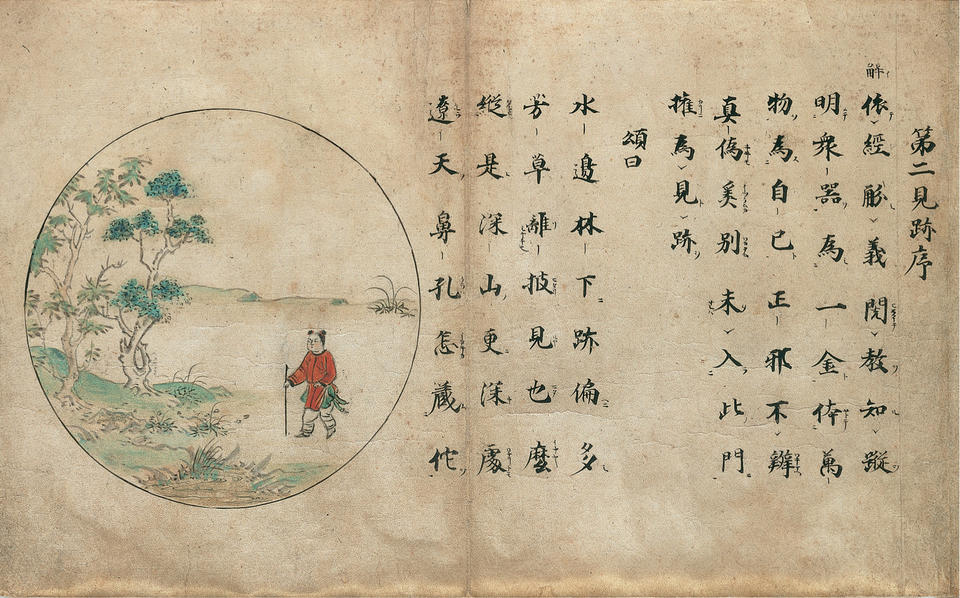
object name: handscroll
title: Ten Verses on Oxherding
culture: japanese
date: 1278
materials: ink, paper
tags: men,ox,parables